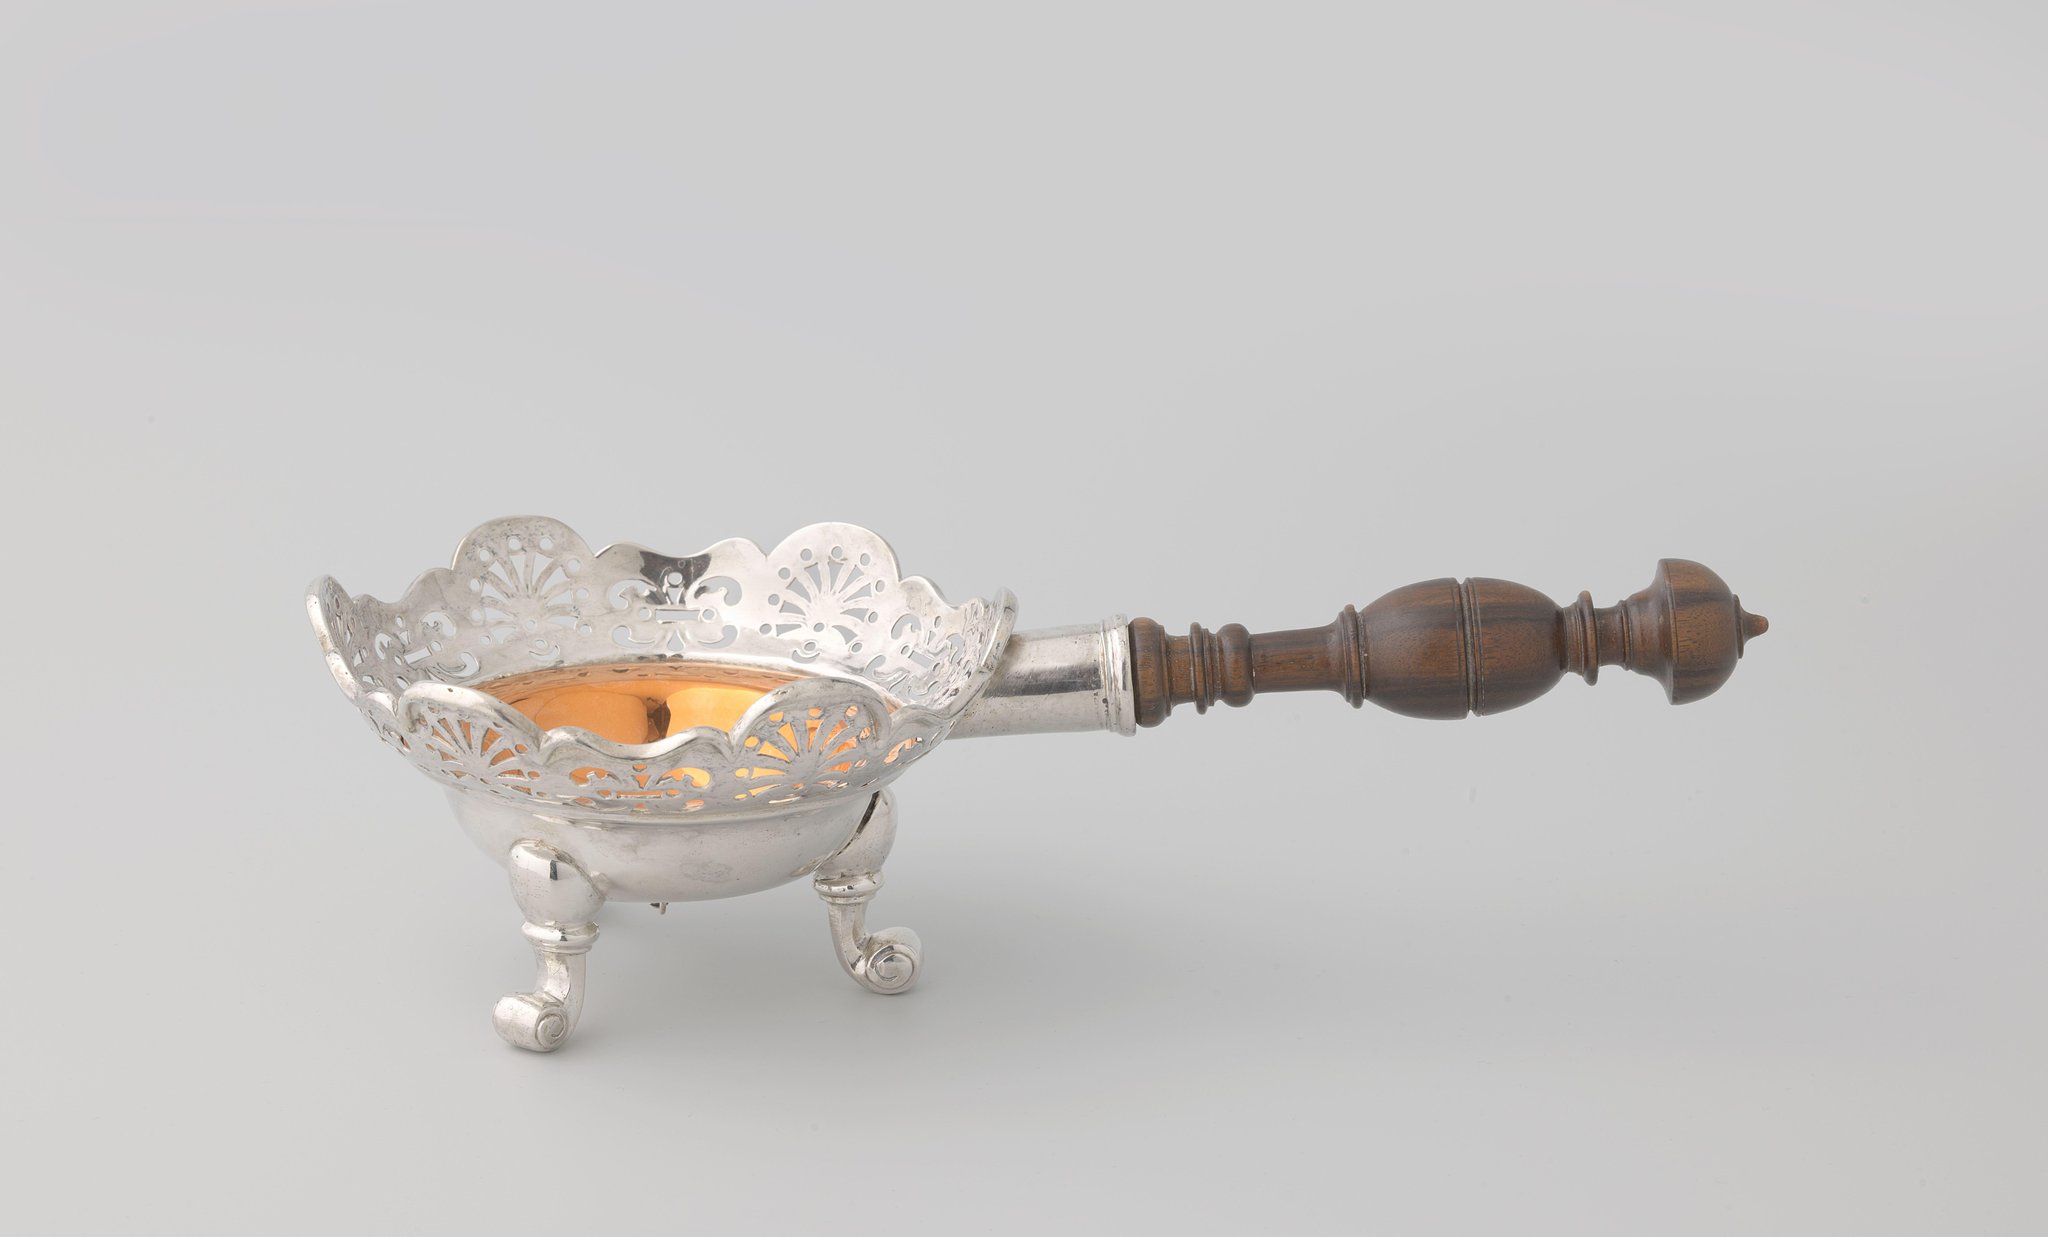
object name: pijpenkomfoor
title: Pijpenkomfoor met opengewerkte geschulpte rand en met gedraaide steel van ebbenhout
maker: Anonymous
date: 1730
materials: copper, wood, silver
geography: batavia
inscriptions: town mark, maker's mark: ‘HS of SH’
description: Pipe lighter. Silver, copper, wood. Indonesia, c. 1740 - 1760. Purchase from Stichting Cultuurgeschiedenis Nederlanders Overzee.